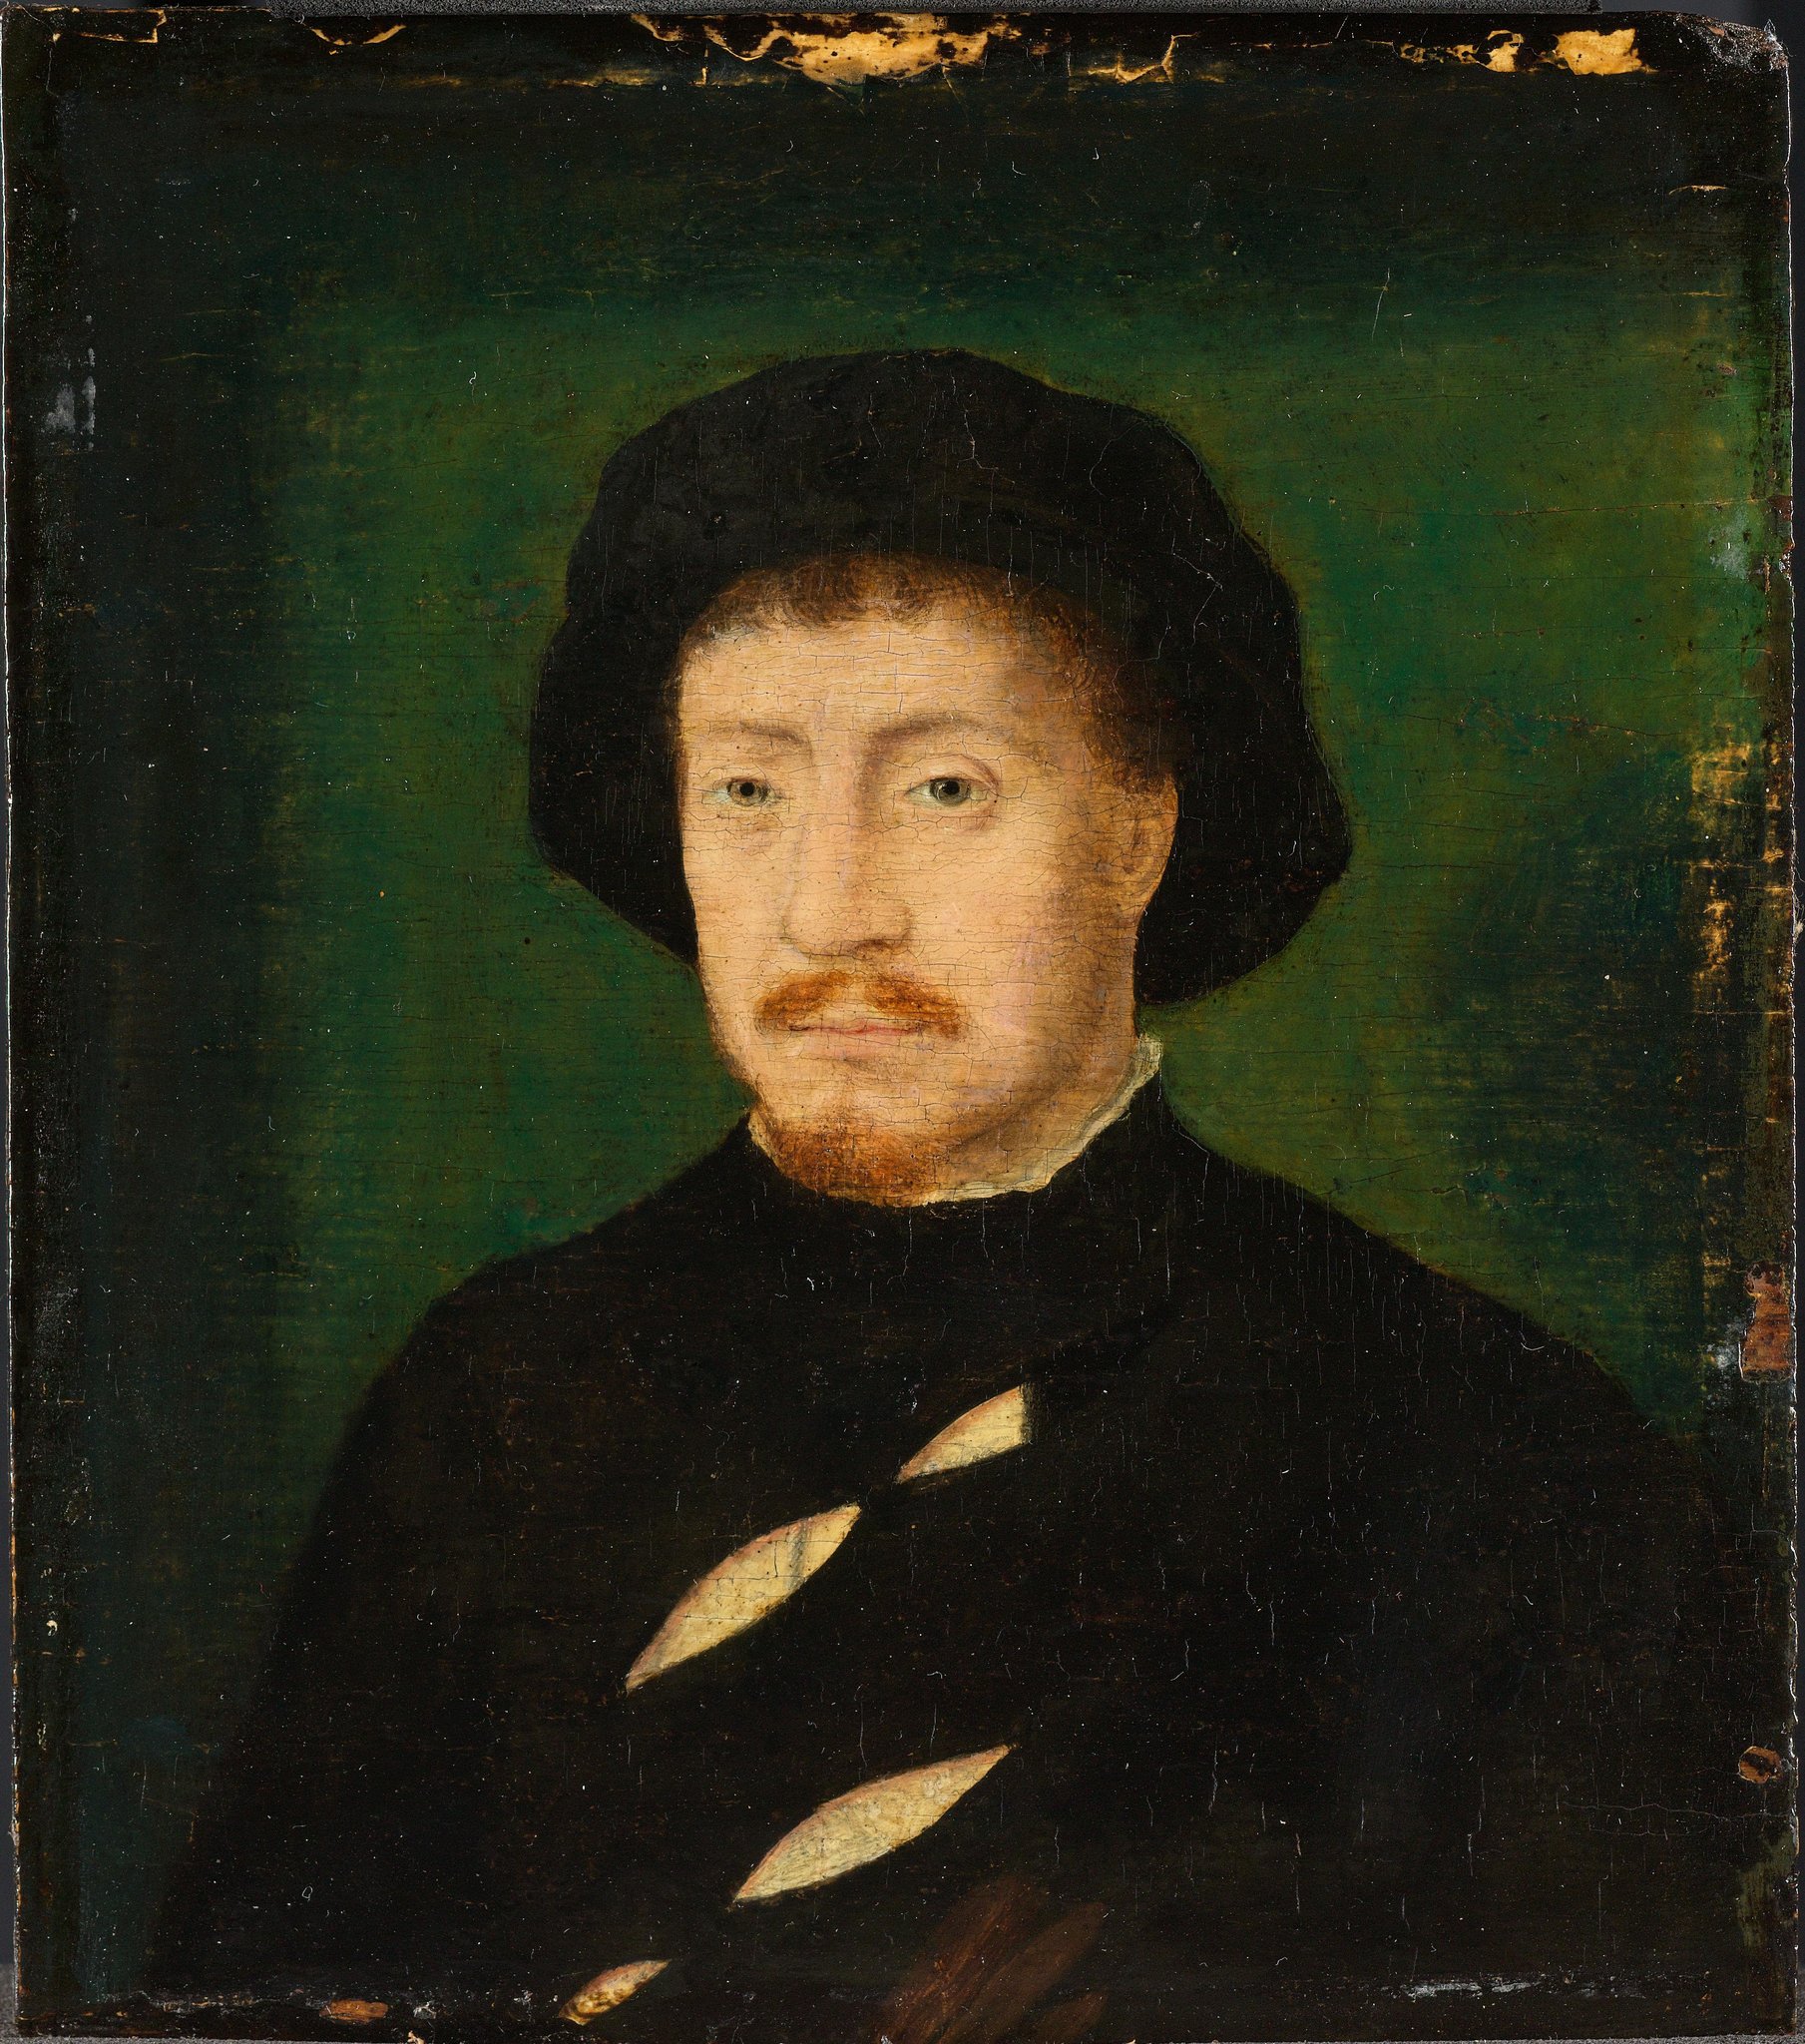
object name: painting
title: Portrait of a Man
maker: corneille de la haye named de lyon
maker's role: painter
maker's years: 1500-1575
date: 1520-1575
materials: oil, panel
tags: anonymous historical person portrayed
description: Portret van een man. Buste met een zwart hoofddekstel.